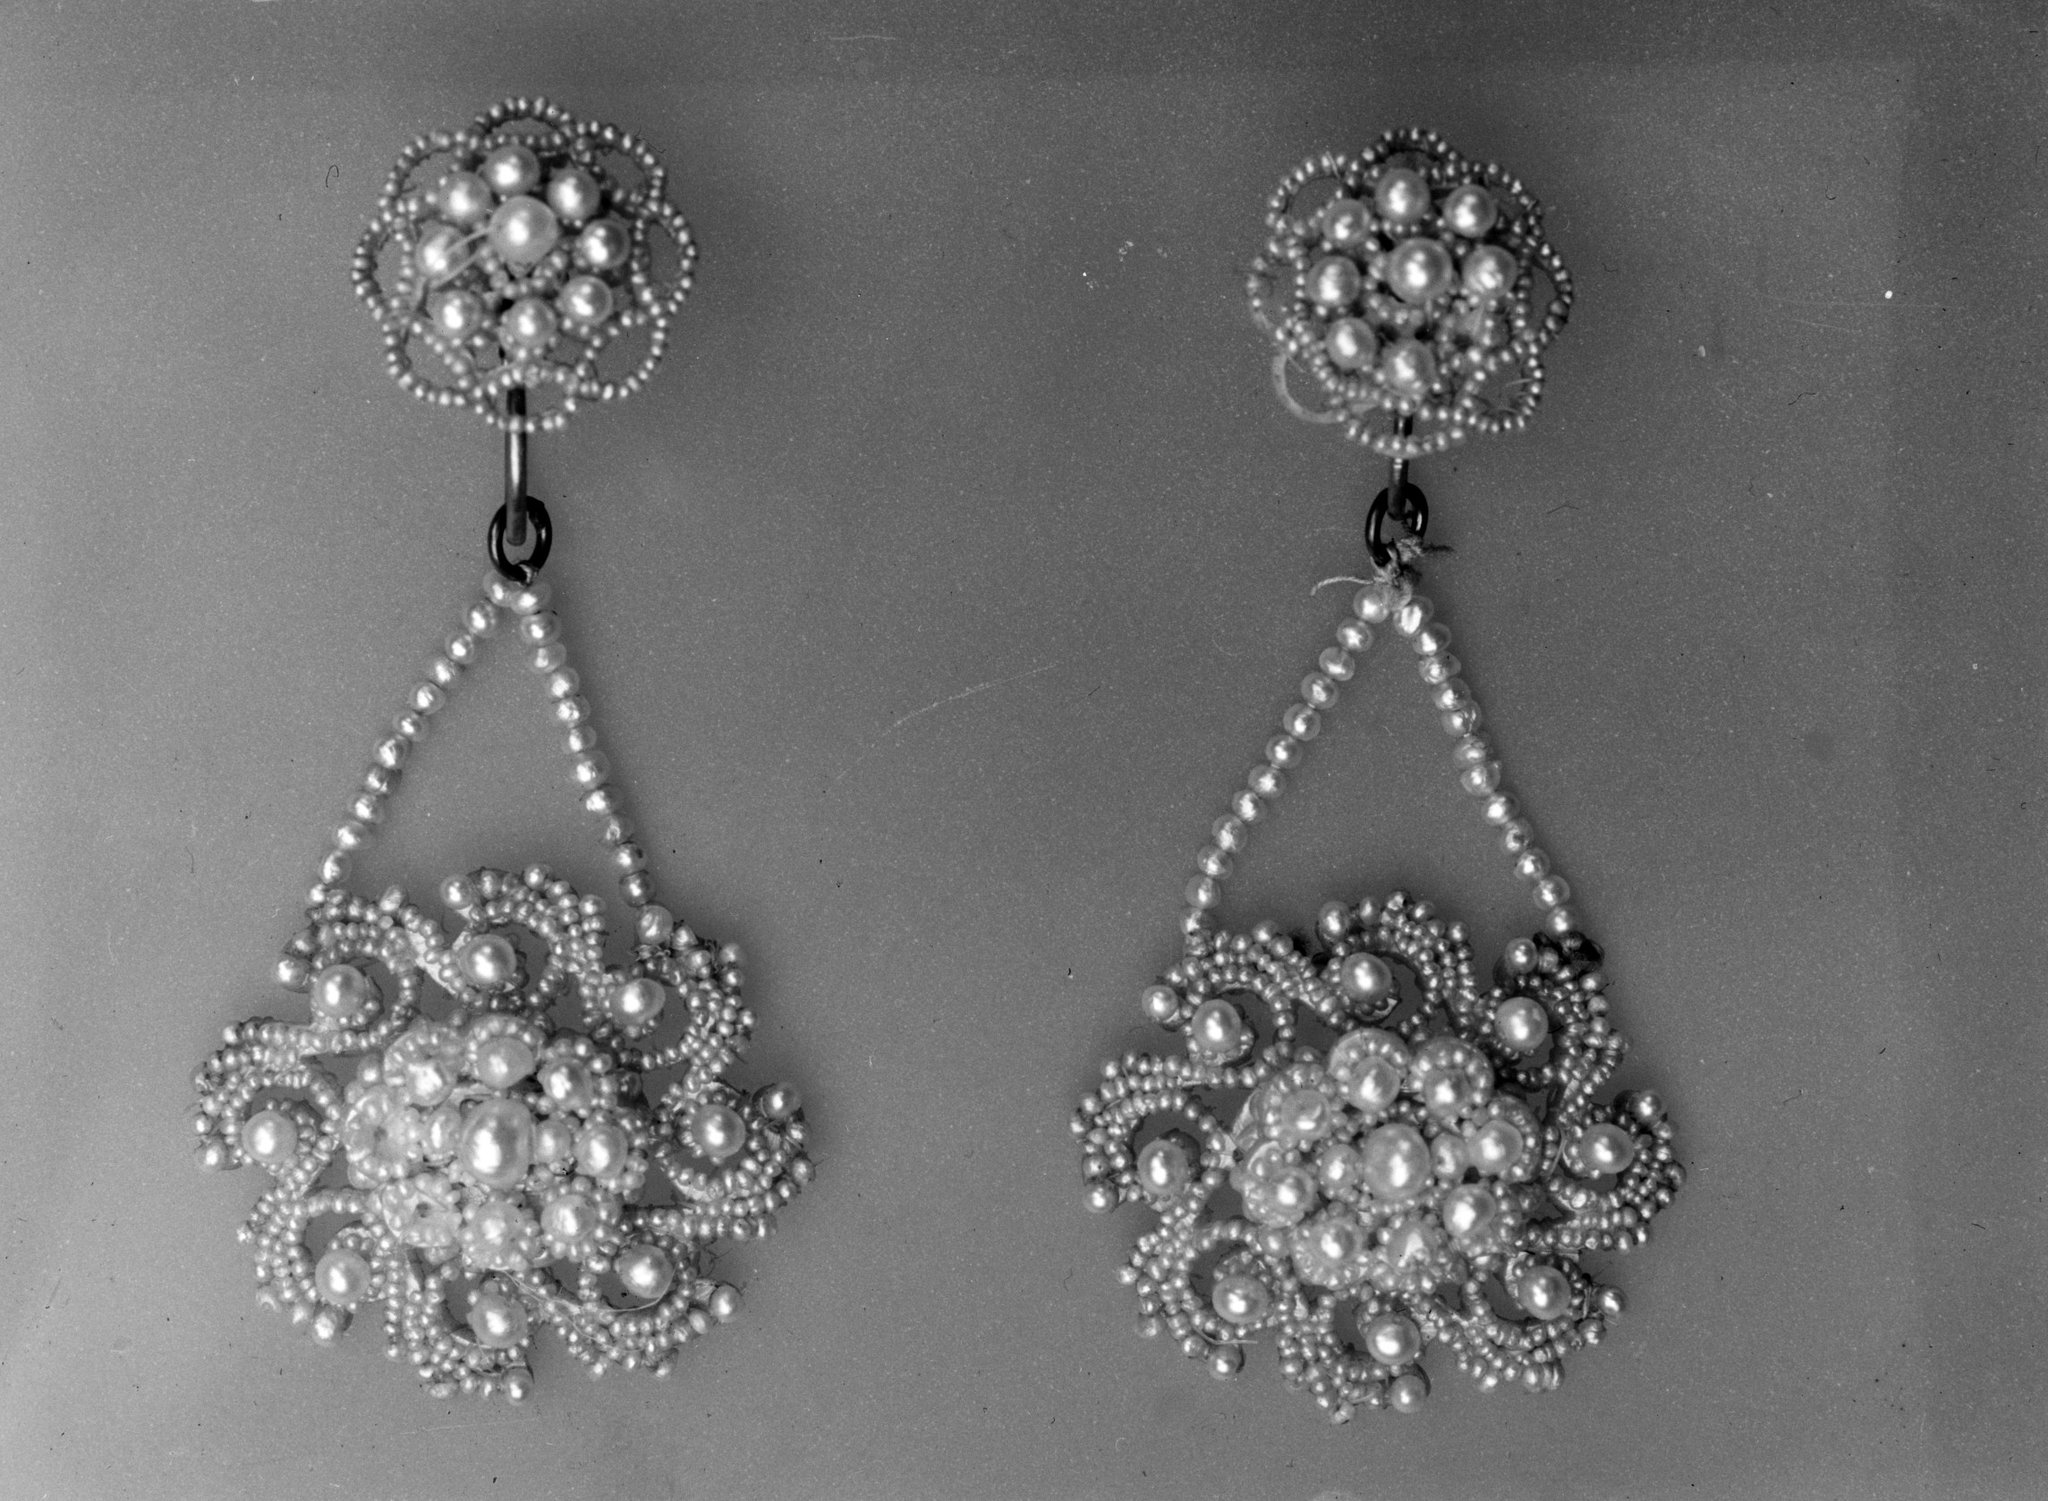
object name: earring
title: Earrings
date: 1800-1900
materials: pearl